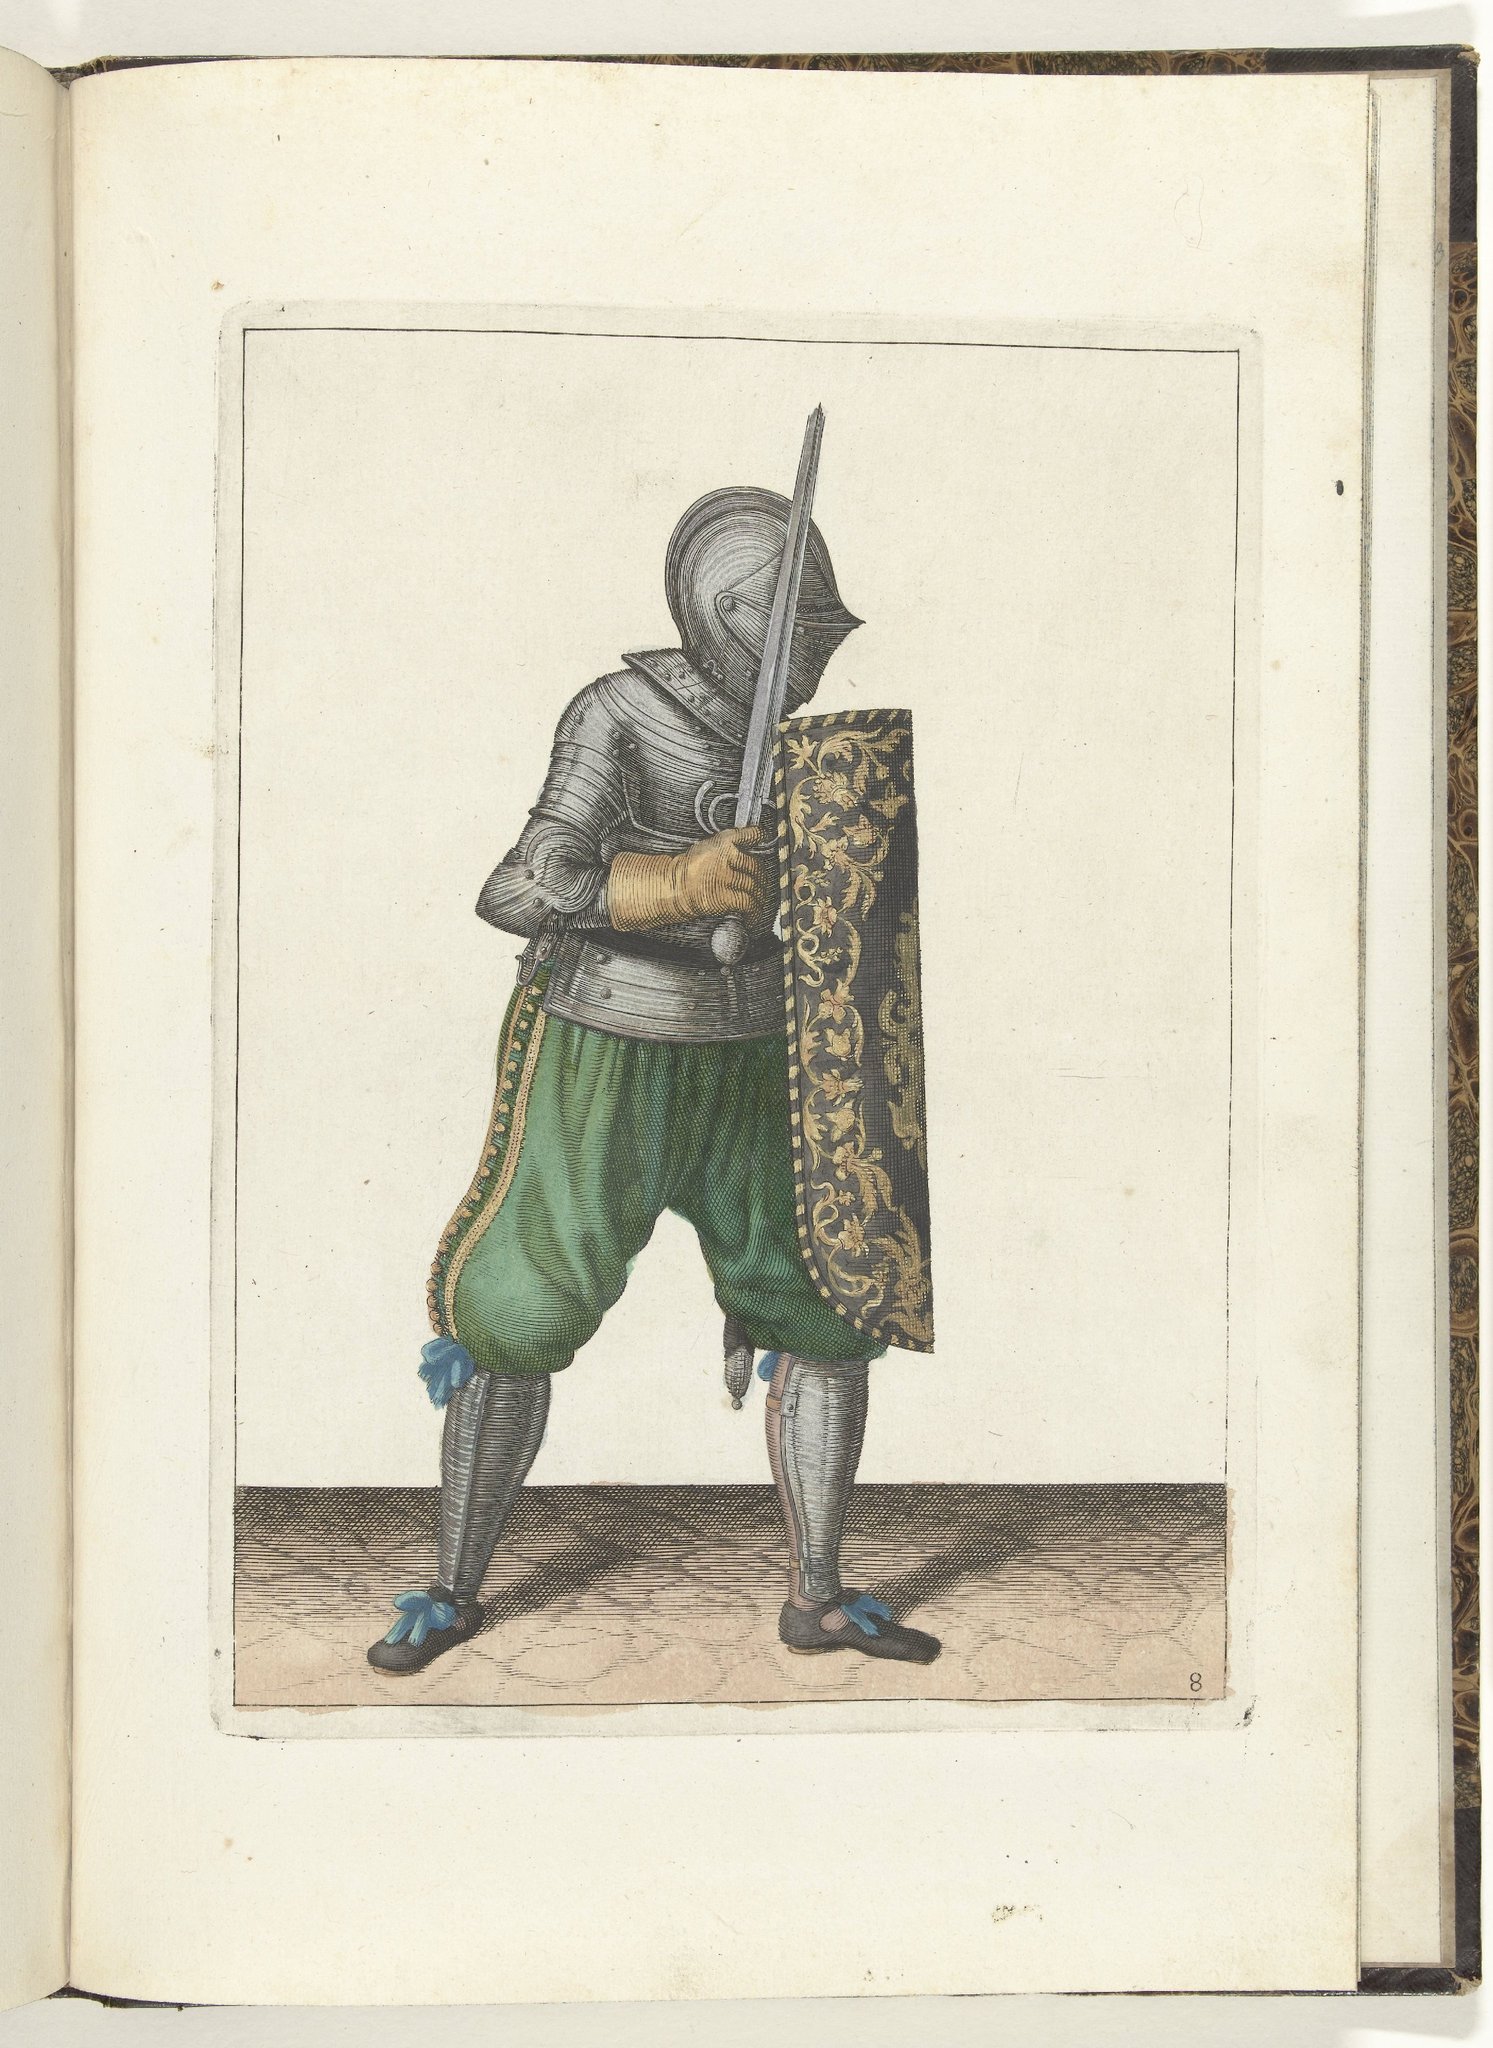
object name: print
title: De exercitie met de targe en rapier: hoe de soldaat zich moet verdedigen met de targe rustend tegen de linkerknie en linkerschouder, de getrokken rapier in de hand (nr. 8), 1618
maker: Anonymous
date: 1616-1618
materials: paper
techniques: engraving, hand coloring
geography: northern netherlands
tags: the hague, maurice (prince of orange), handling of weapons ~ military training, weapons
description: Illustratie in: Adam van Breen, Nassauische Waffenhandelung / Kurtzer Bericht unnd Ahnzeigungh auff die Ab-bildungh der Figuren / den rechten brauch alles des jenigen betreffend / so einem Soldaten von nöten / in der handlung der Targa, met dem Degen [incompleet exemplaar], 1618?, plaat 8. Dit is een Duitse editie van Adam van Breens De Nassausche Wapen-Handelinge, van Schilt, Spies, Rappier ende Targe : beyde figuerlick afgebeelt, ende gestelt na de nieu ordening [van] ... Maurits van Nassau, 's-Gravenhage, [Aert Meuris] 1618. In het exemplaar in de collectie van de Rijksmuseum Research Library (326 F 23).